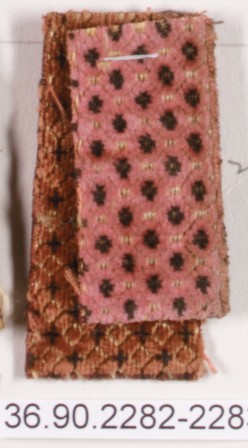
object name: piece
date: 1801-1900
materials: silk